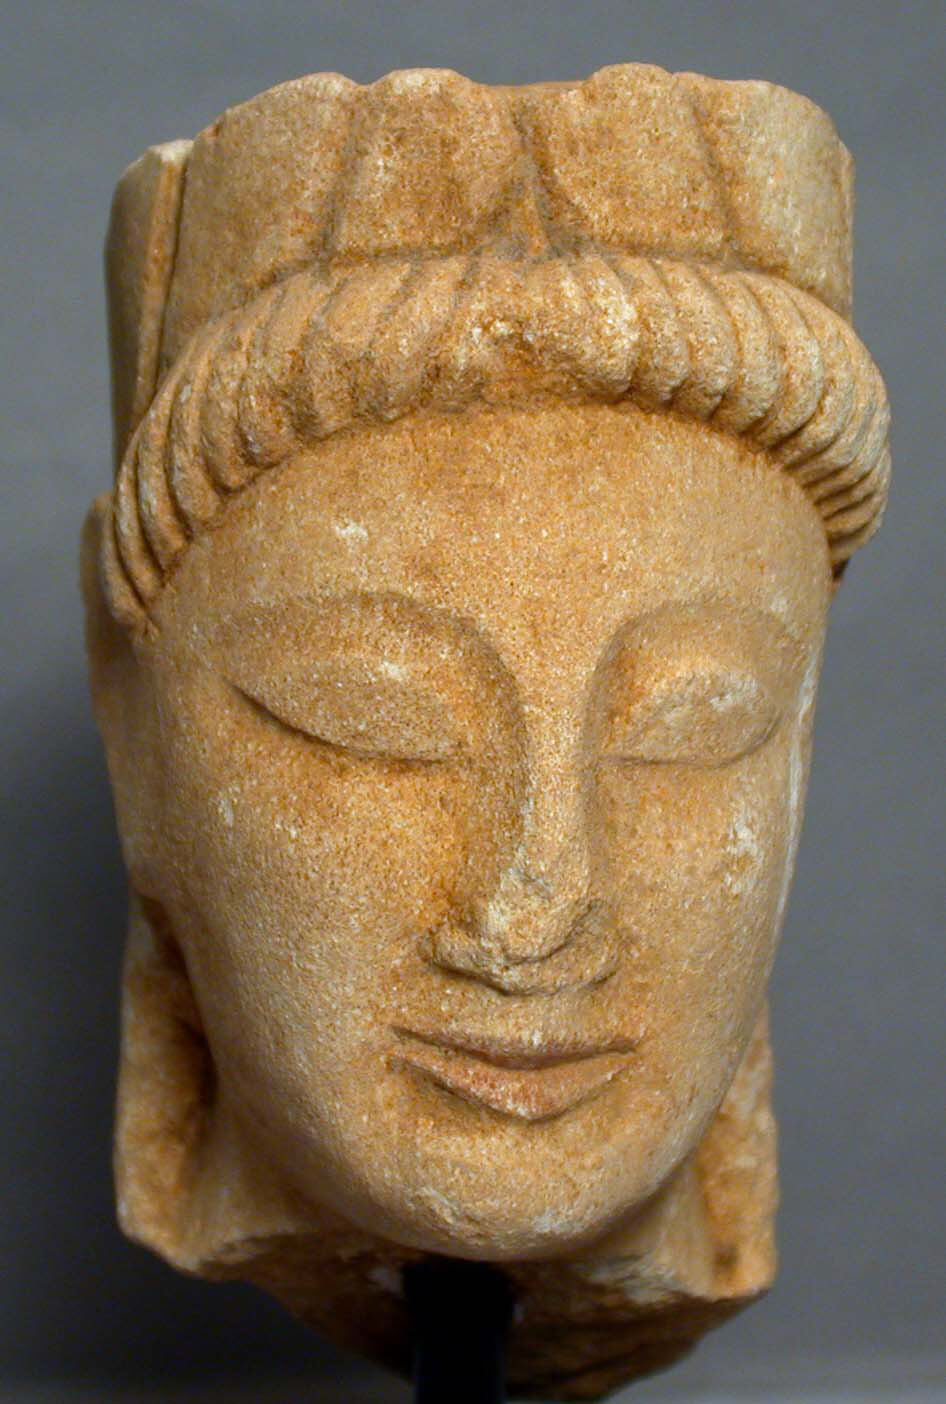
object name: male head with wreath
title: Limestone male head with wreath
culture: cypriot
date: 600-501 BCE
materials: limestone